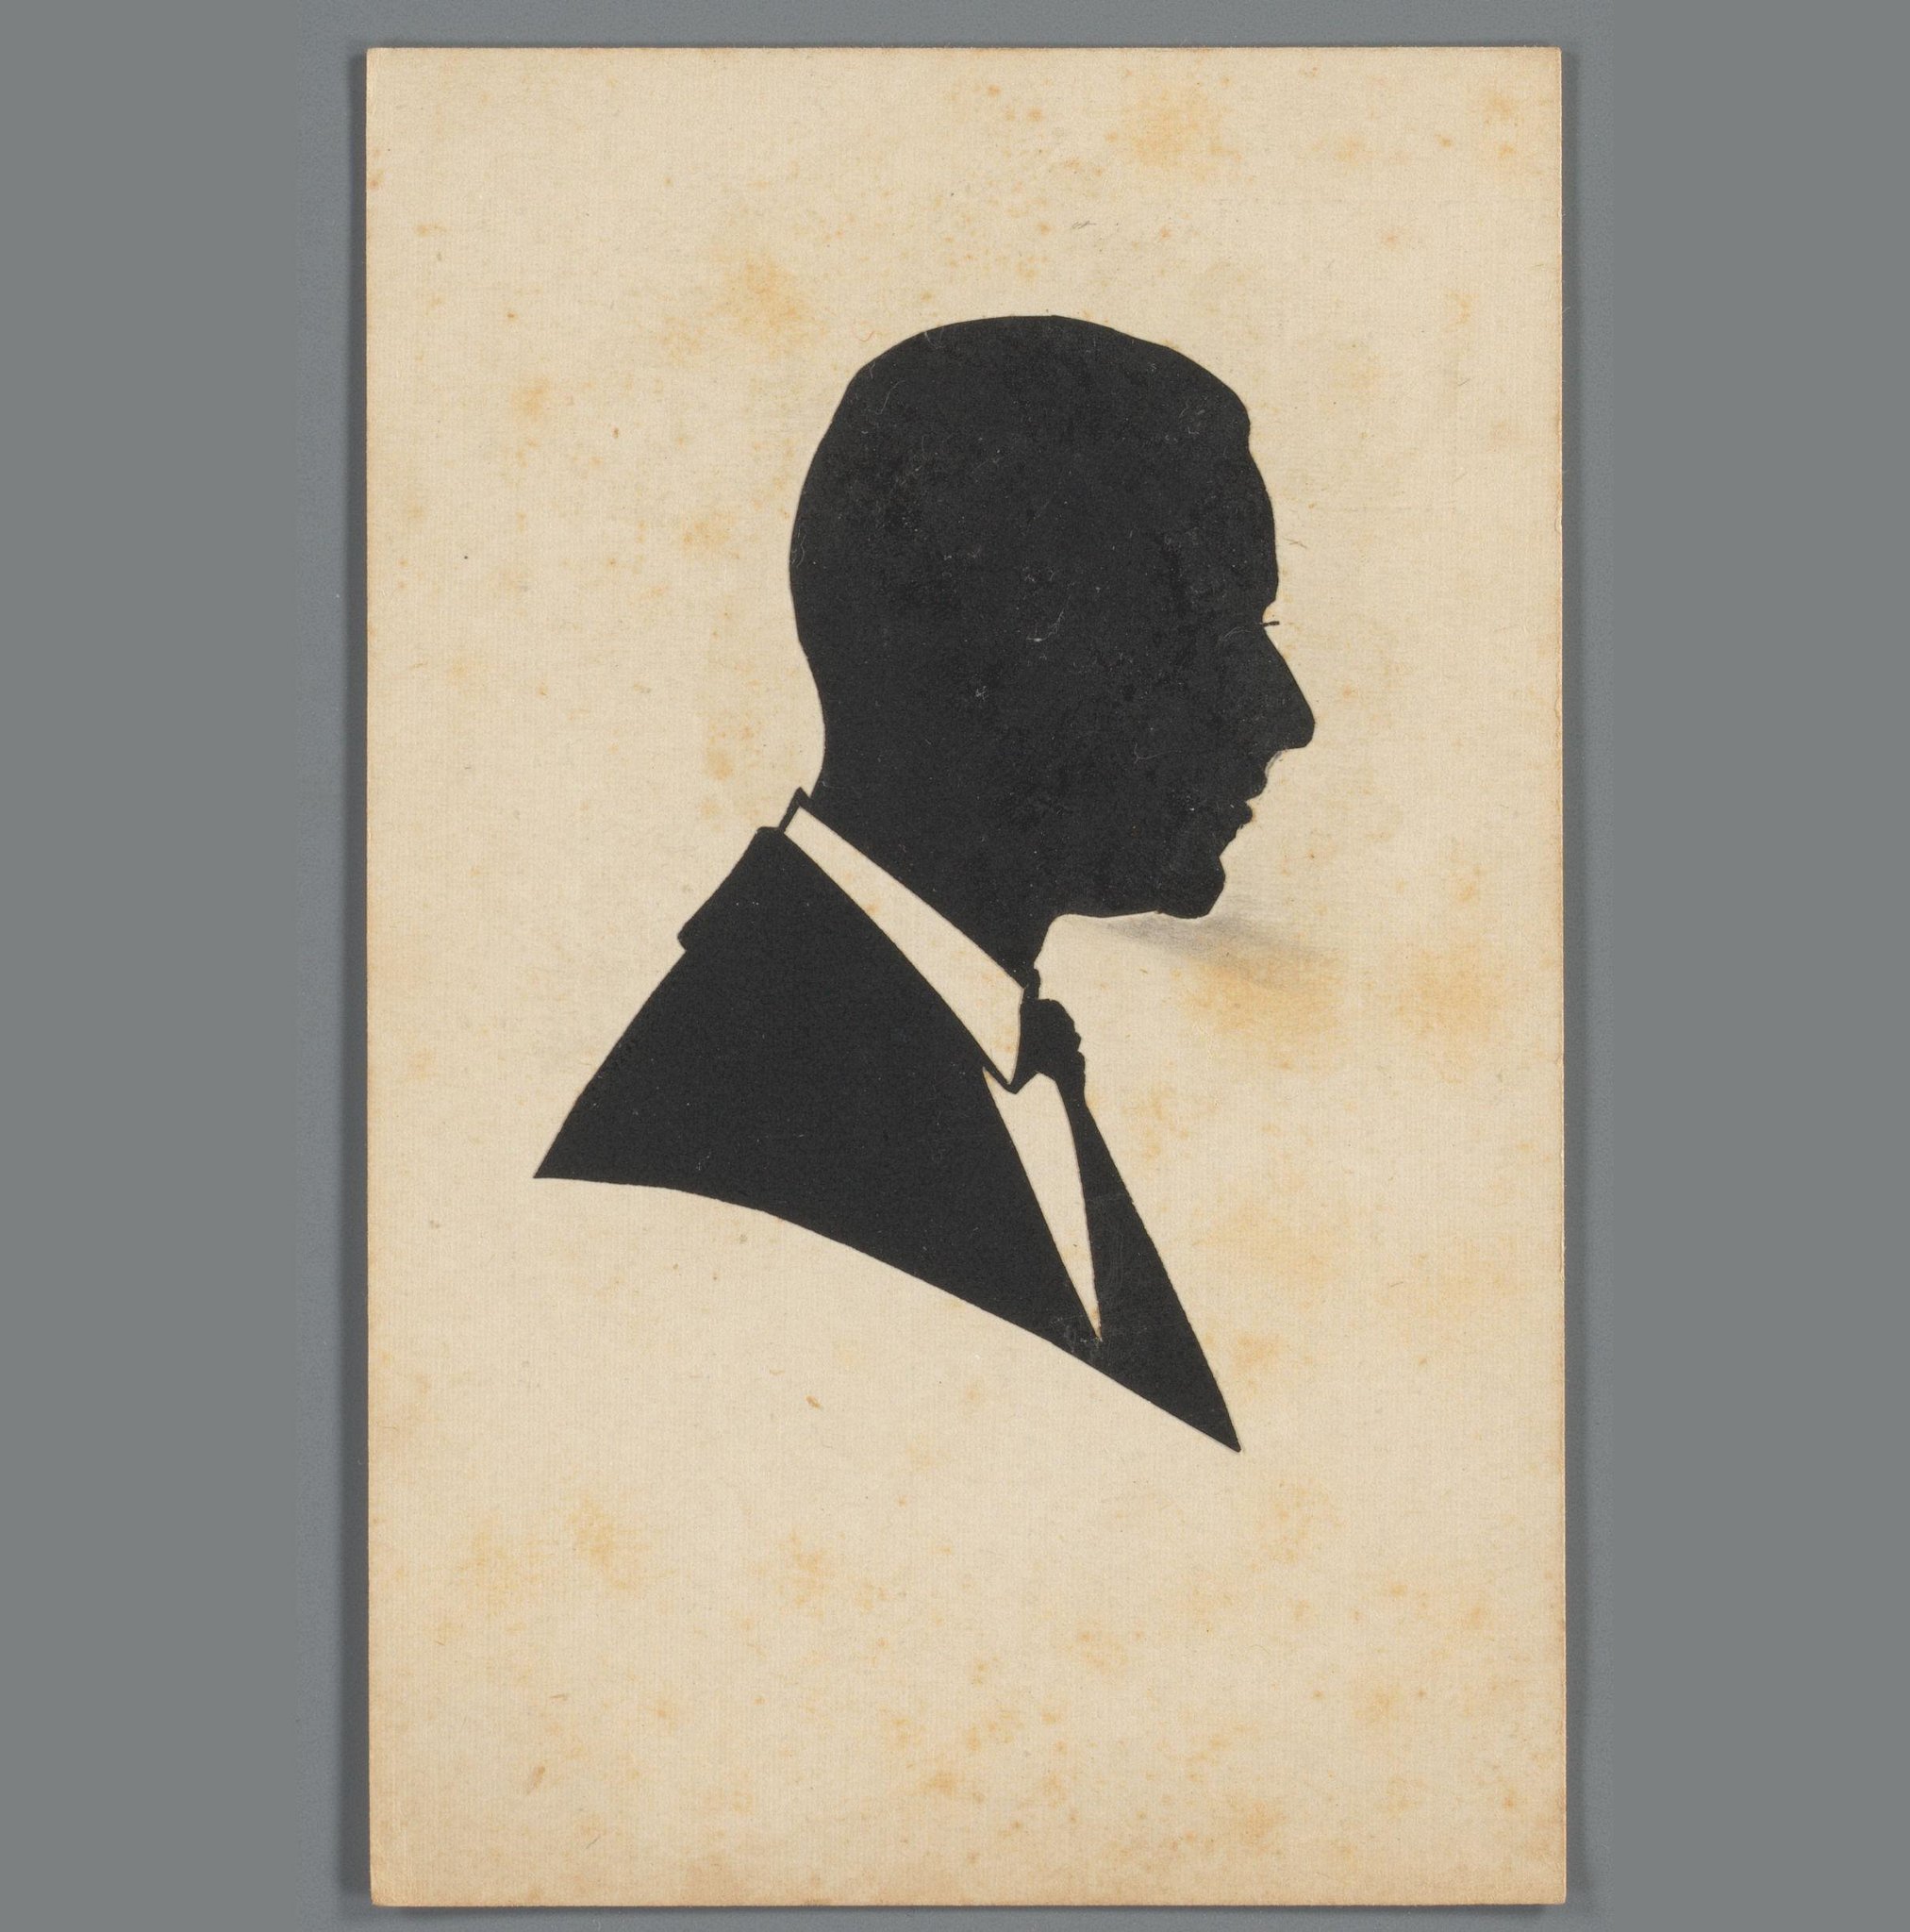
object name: cut paper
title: Silhouetportret van een onbekende man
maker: Anonymous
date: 1890-1905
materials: cardboard, paper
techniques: snipping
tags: anonymous historical person portrayed